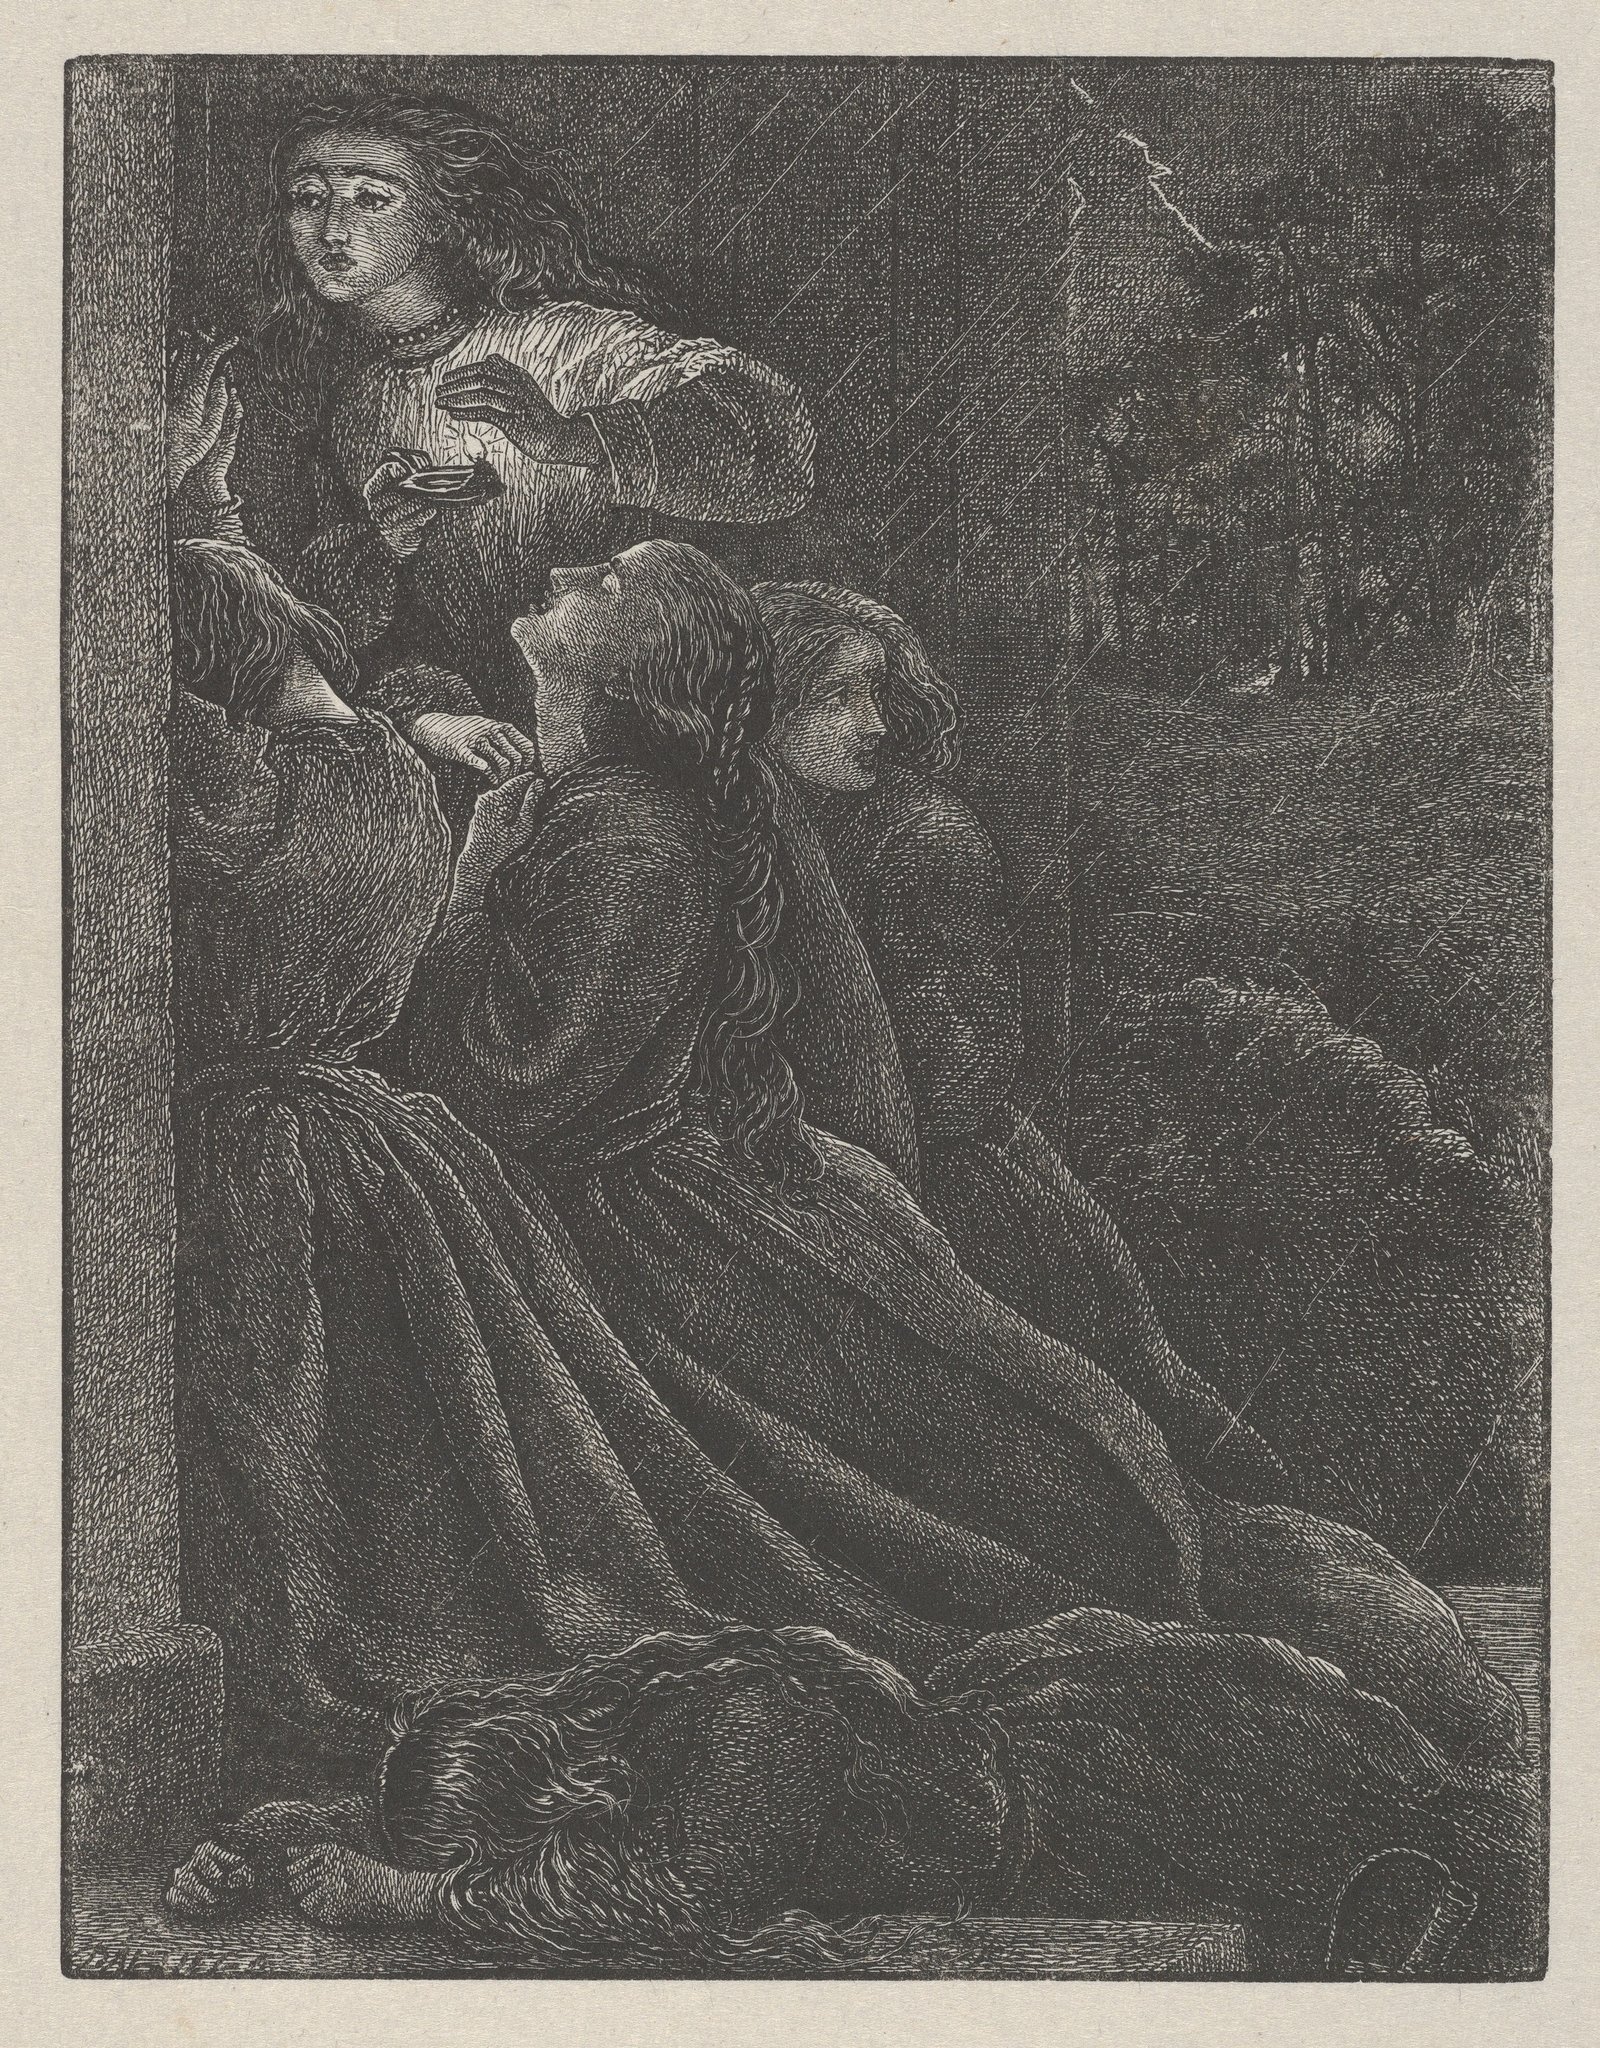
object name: print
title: The Foolish Virgins (The Parables of Our Lord and Saviour Jesus Christ)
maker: sir john everett millais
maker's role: artist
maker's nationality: british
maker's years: 1829-1896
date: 1864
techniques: engraving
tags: virgin mary